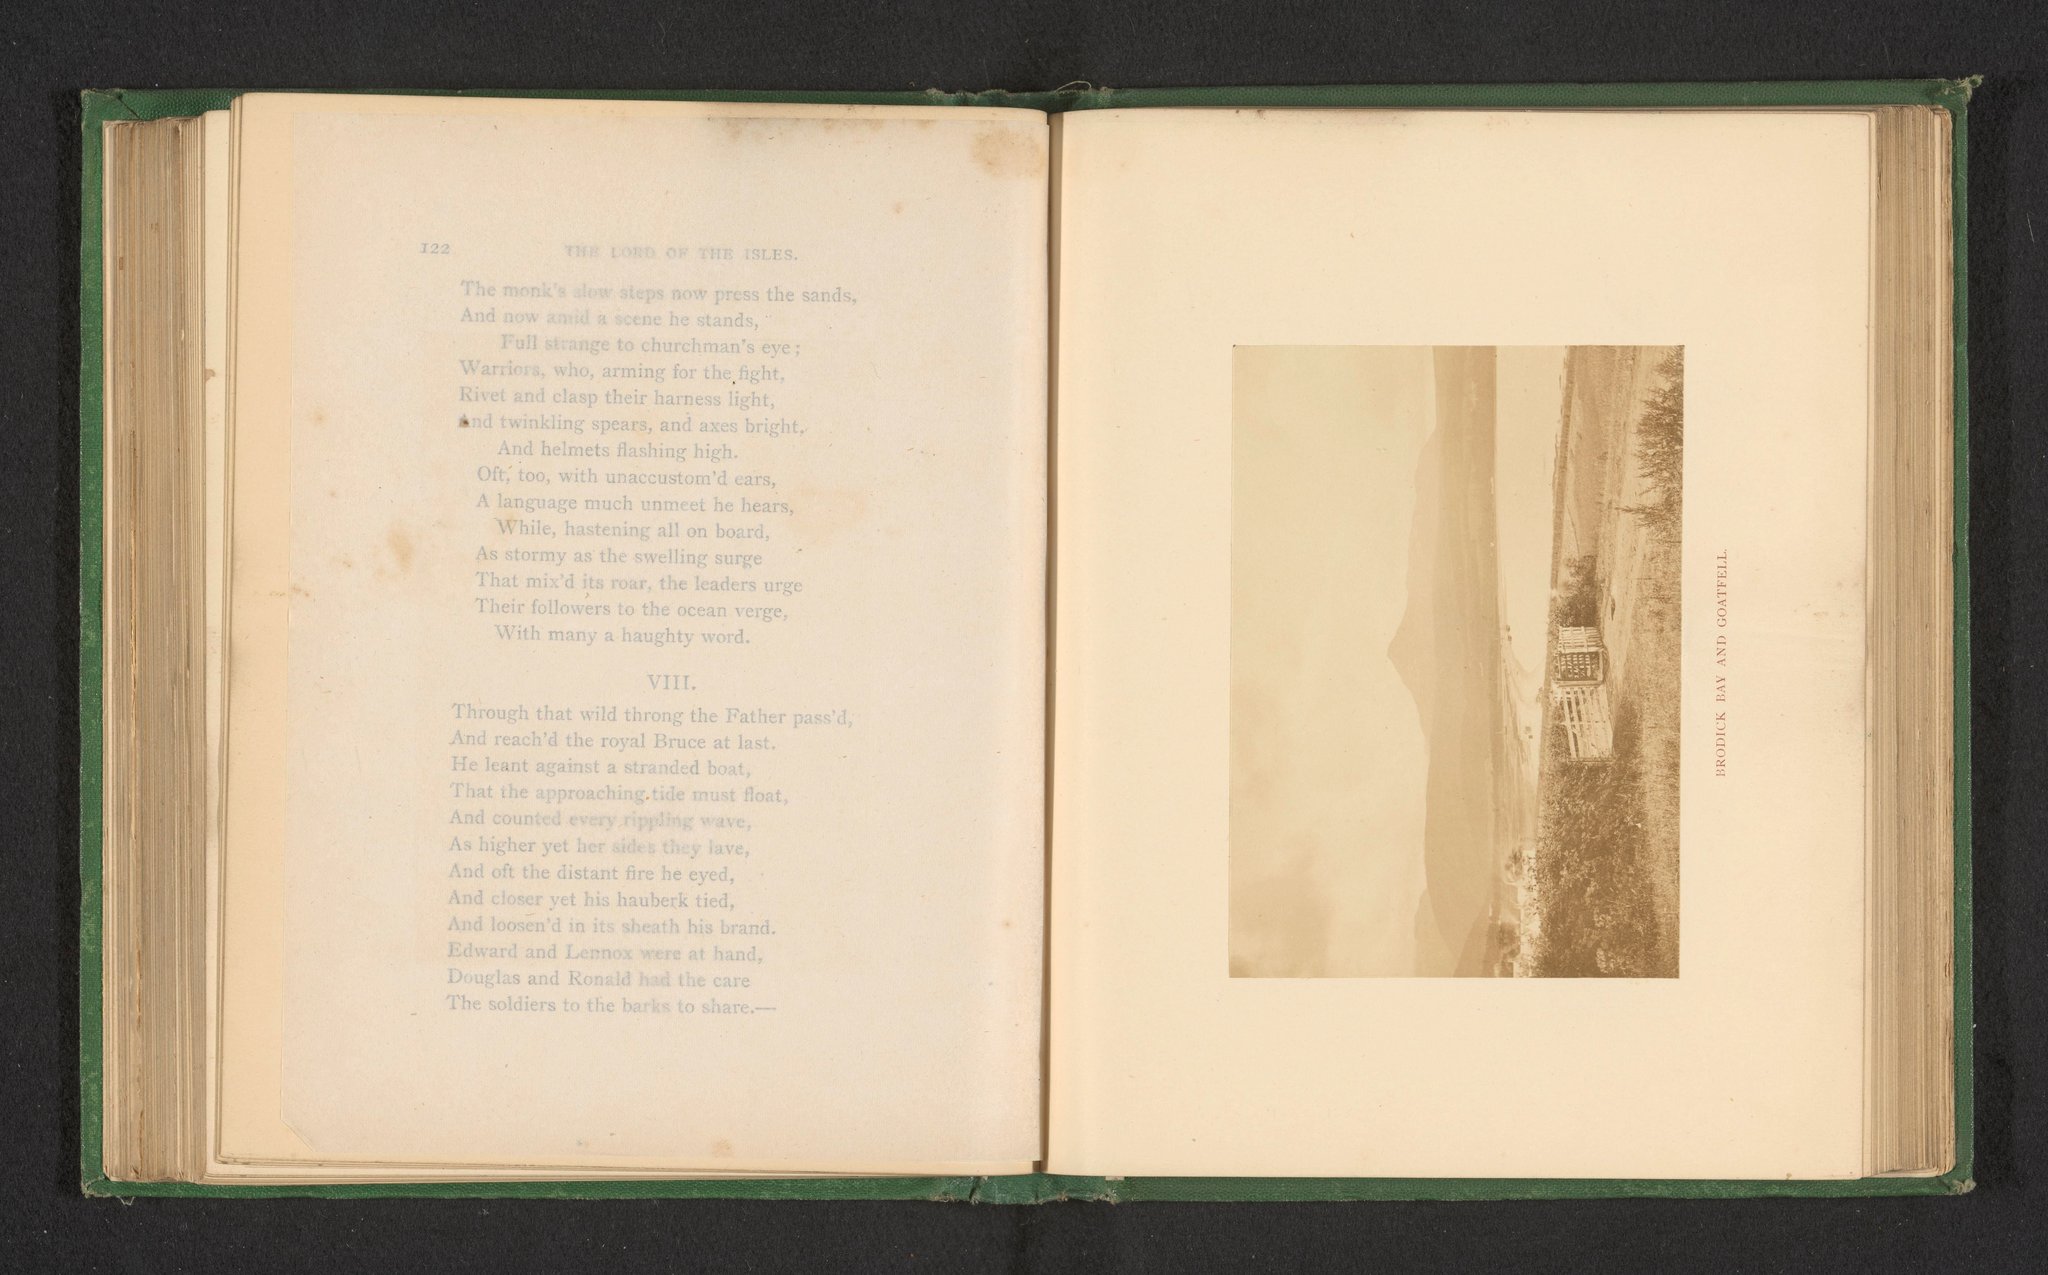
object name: photograph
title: Brodick Bay and Goatfell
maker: william russell sedgfield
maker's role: fotograaf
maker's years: 1826-1902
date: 1861-1871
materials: photographic support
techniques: albumen print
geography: brodick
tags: gulf, bay, mountain-top, peak